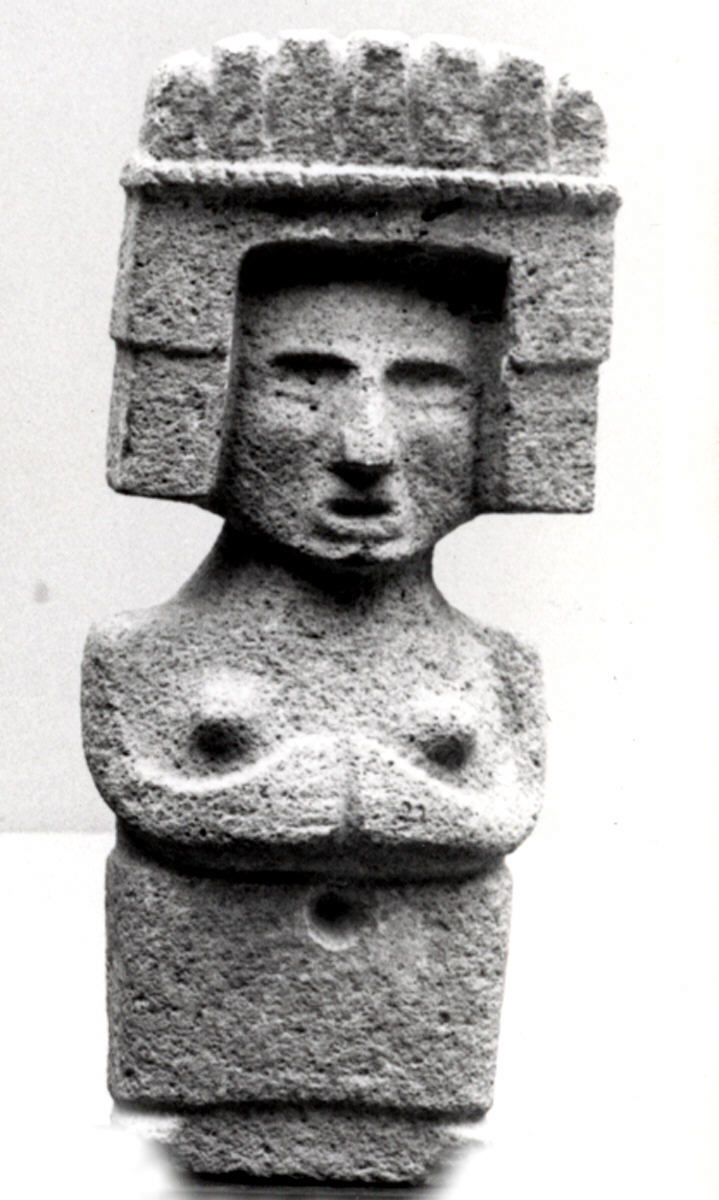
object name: figure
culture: mexica, aztec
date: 1301-1500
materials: stone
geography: mexico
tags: women